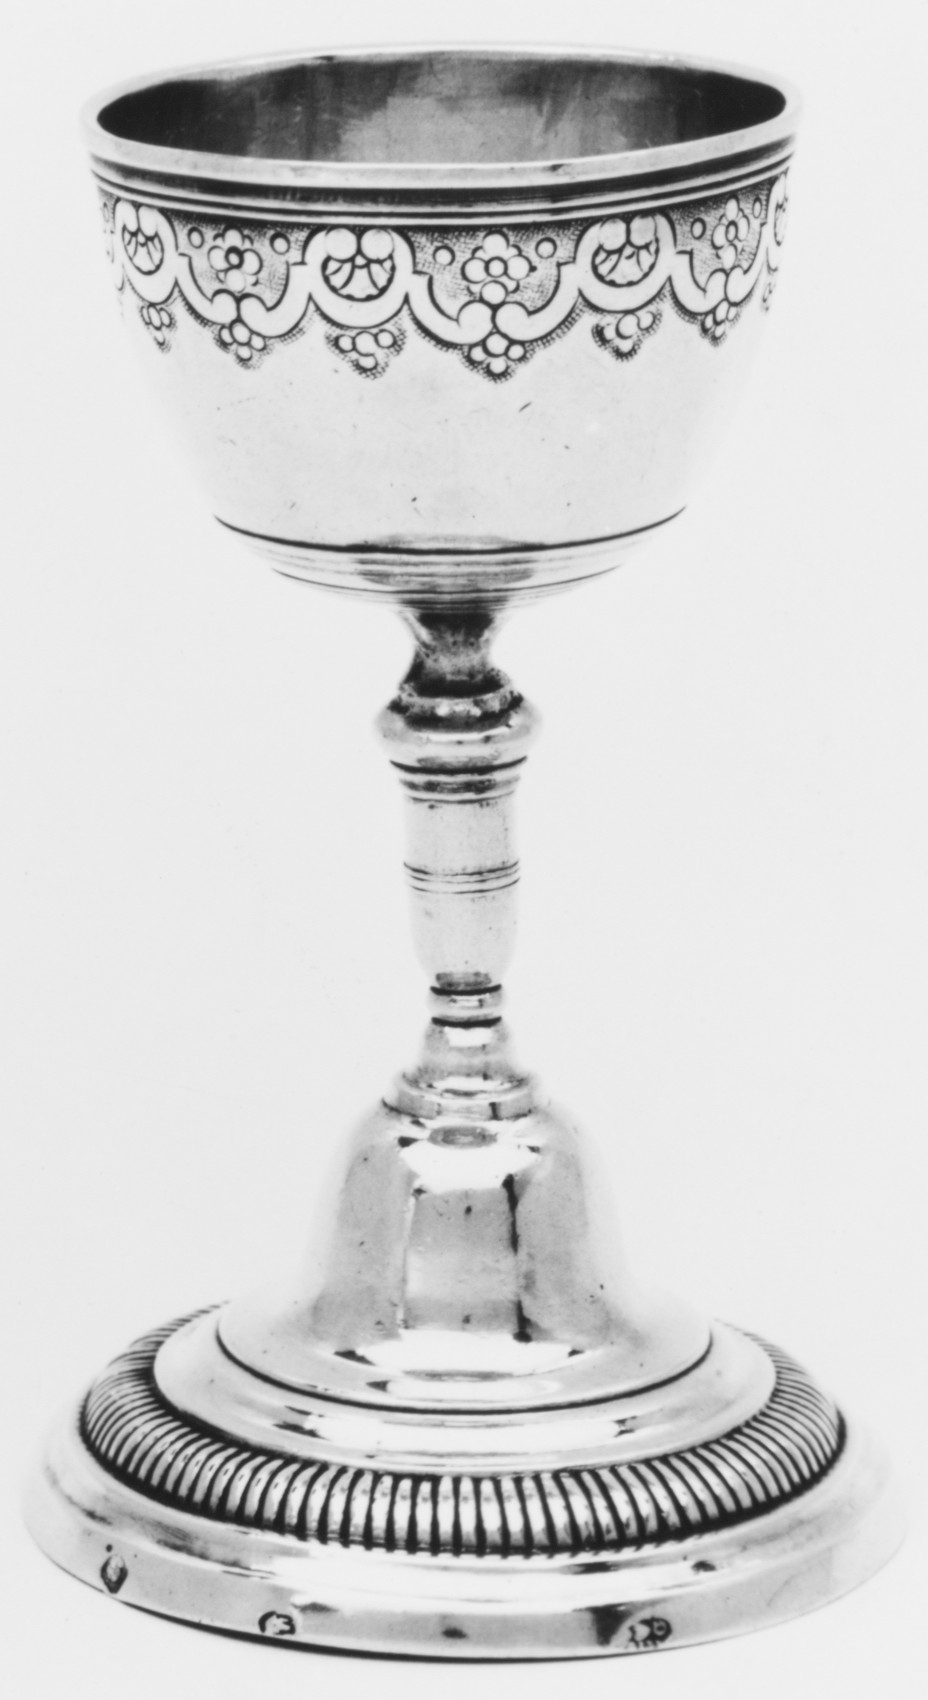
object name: egg cup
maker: claude-françois gaucher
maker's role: maker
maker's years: 1656-1756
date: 1742-1743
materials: silver